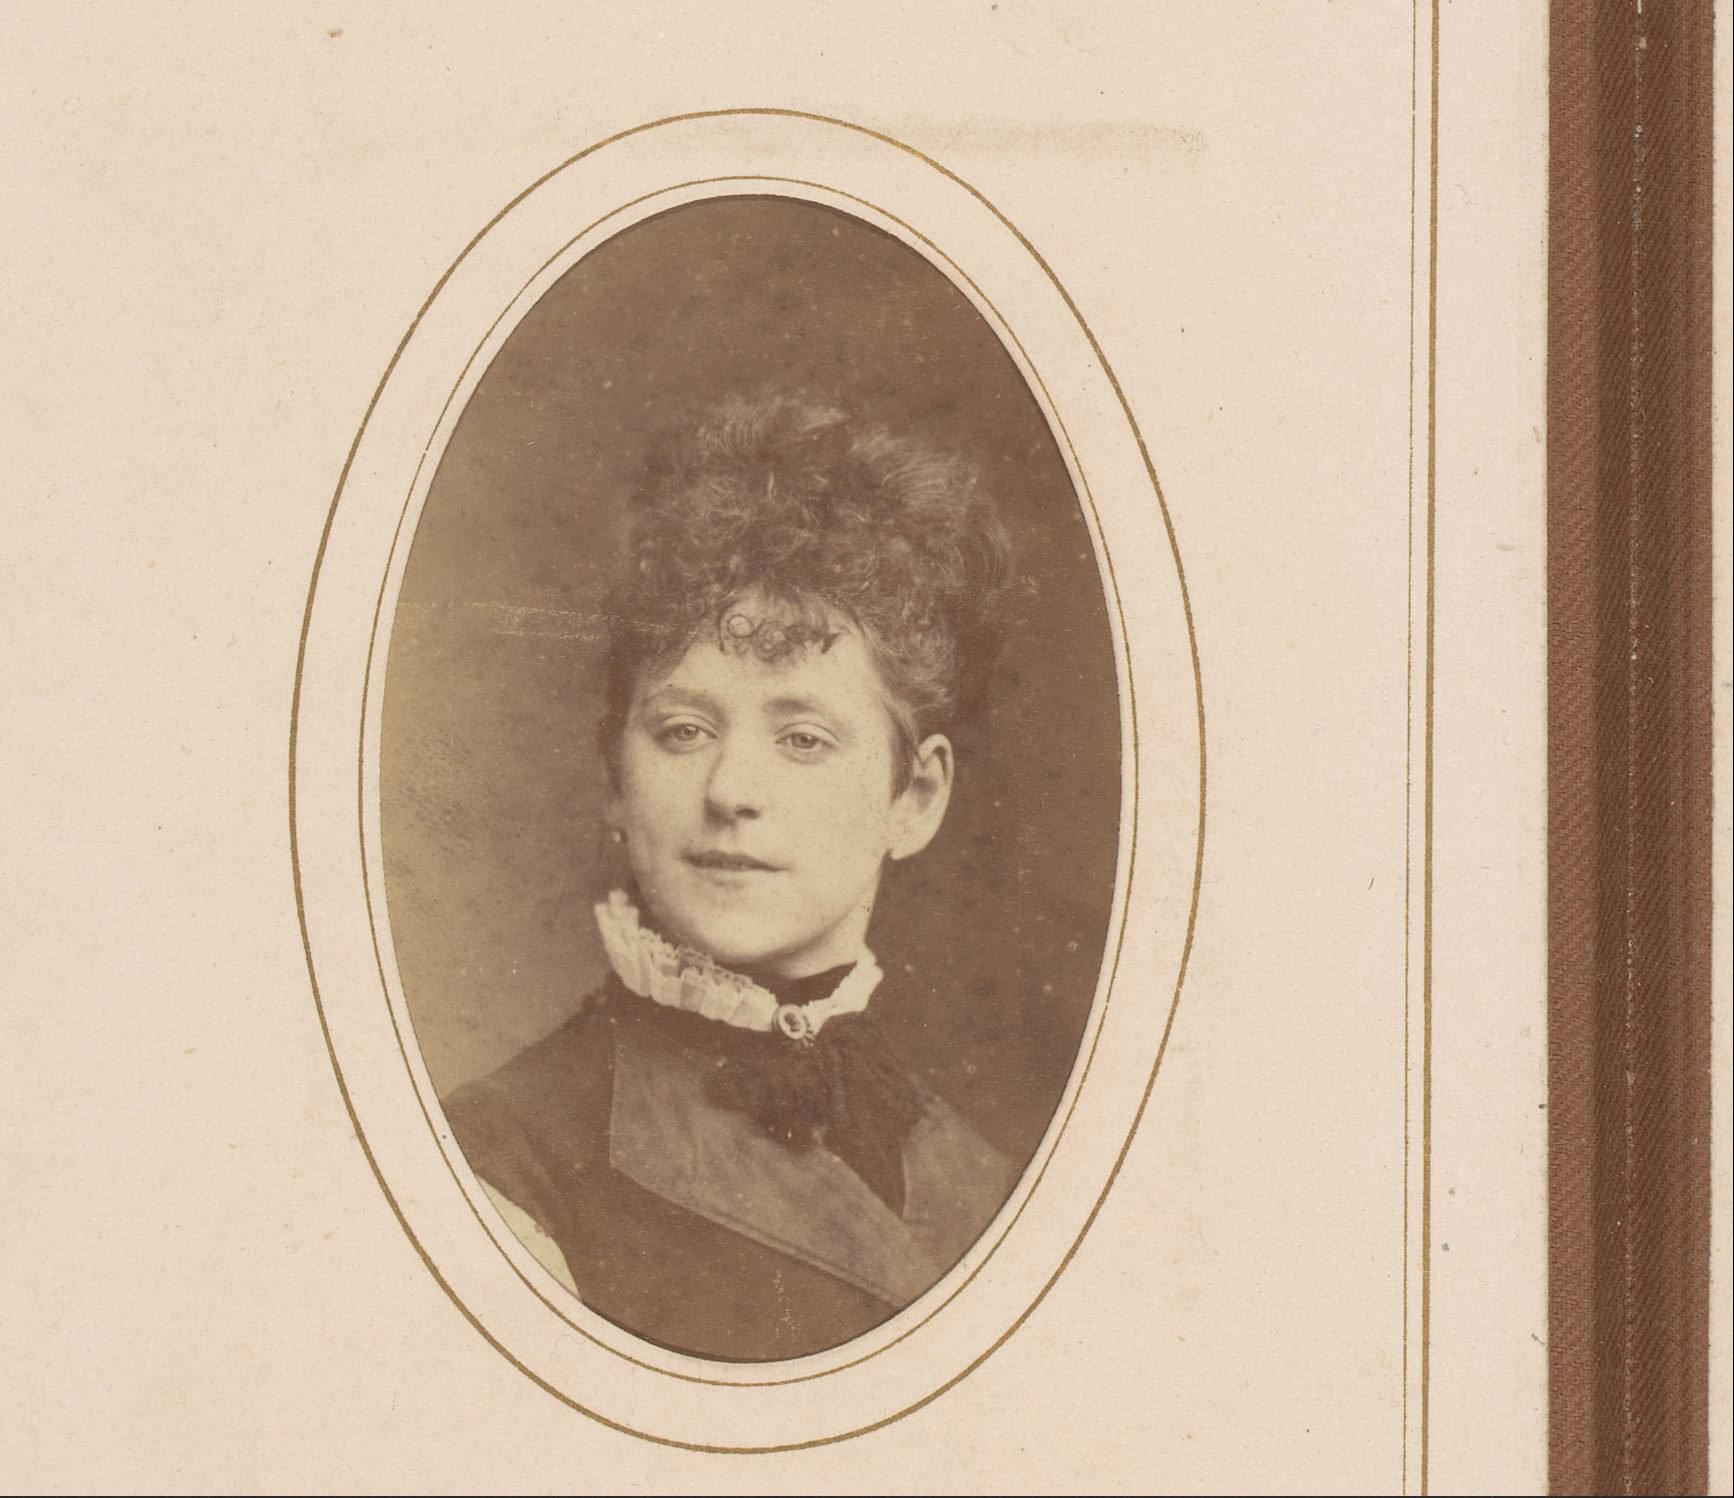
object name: photograph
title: Portret van jonge vrouw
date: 1868-1882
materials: cardboard, photographic support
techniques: albumen print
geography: netherlands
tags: adolescent, young woman, maiden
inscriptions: inscription: ‘Wegner & Mottu/ Amsterdam/ Rokin D. 26 en Kalverstraat D. 26/ Utrecht/ Leijdschestraatweg I, 153’